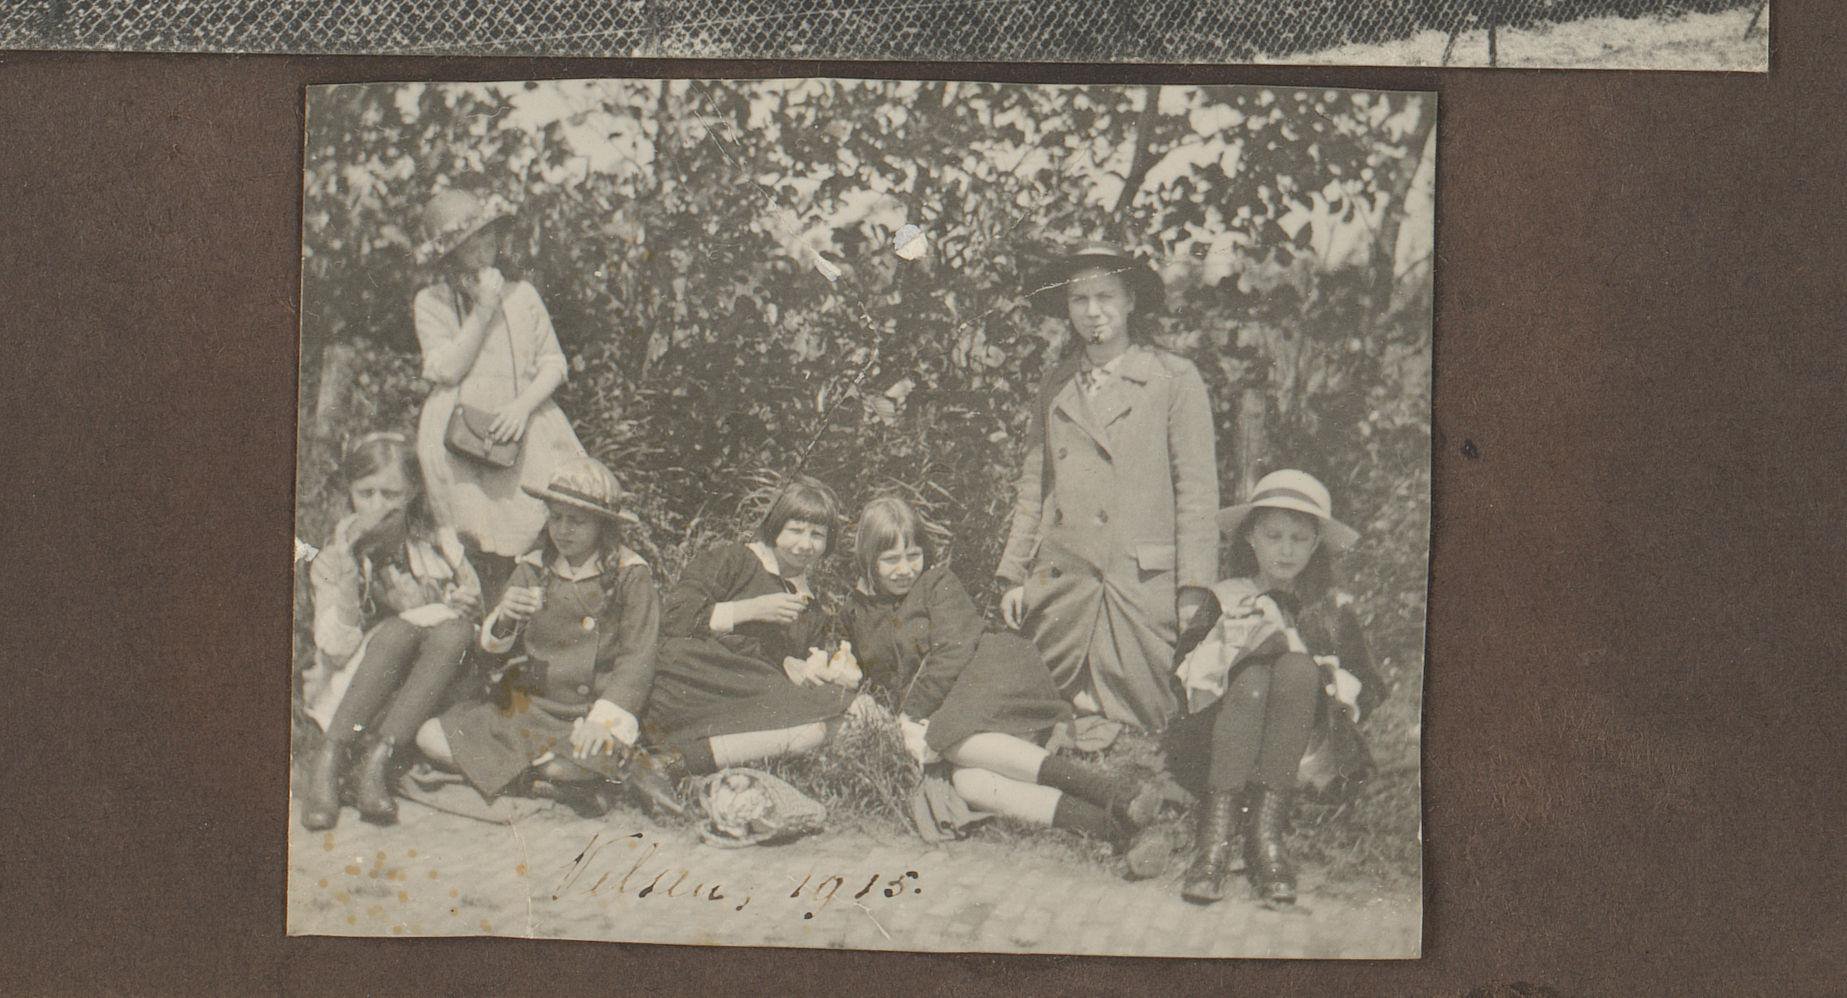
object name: photograph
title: Groepsportret van zeven meisjes in het gras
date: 1915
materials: paper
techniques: matte daylight collodion silver print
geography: netherlands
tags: adolescent, young woman, maiden, historical person (with name) - bb - woman - historical person (with name) portrayed in a group, in a group-portrait, village lane, alley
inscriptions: inscription: ‘[...] 1915.’